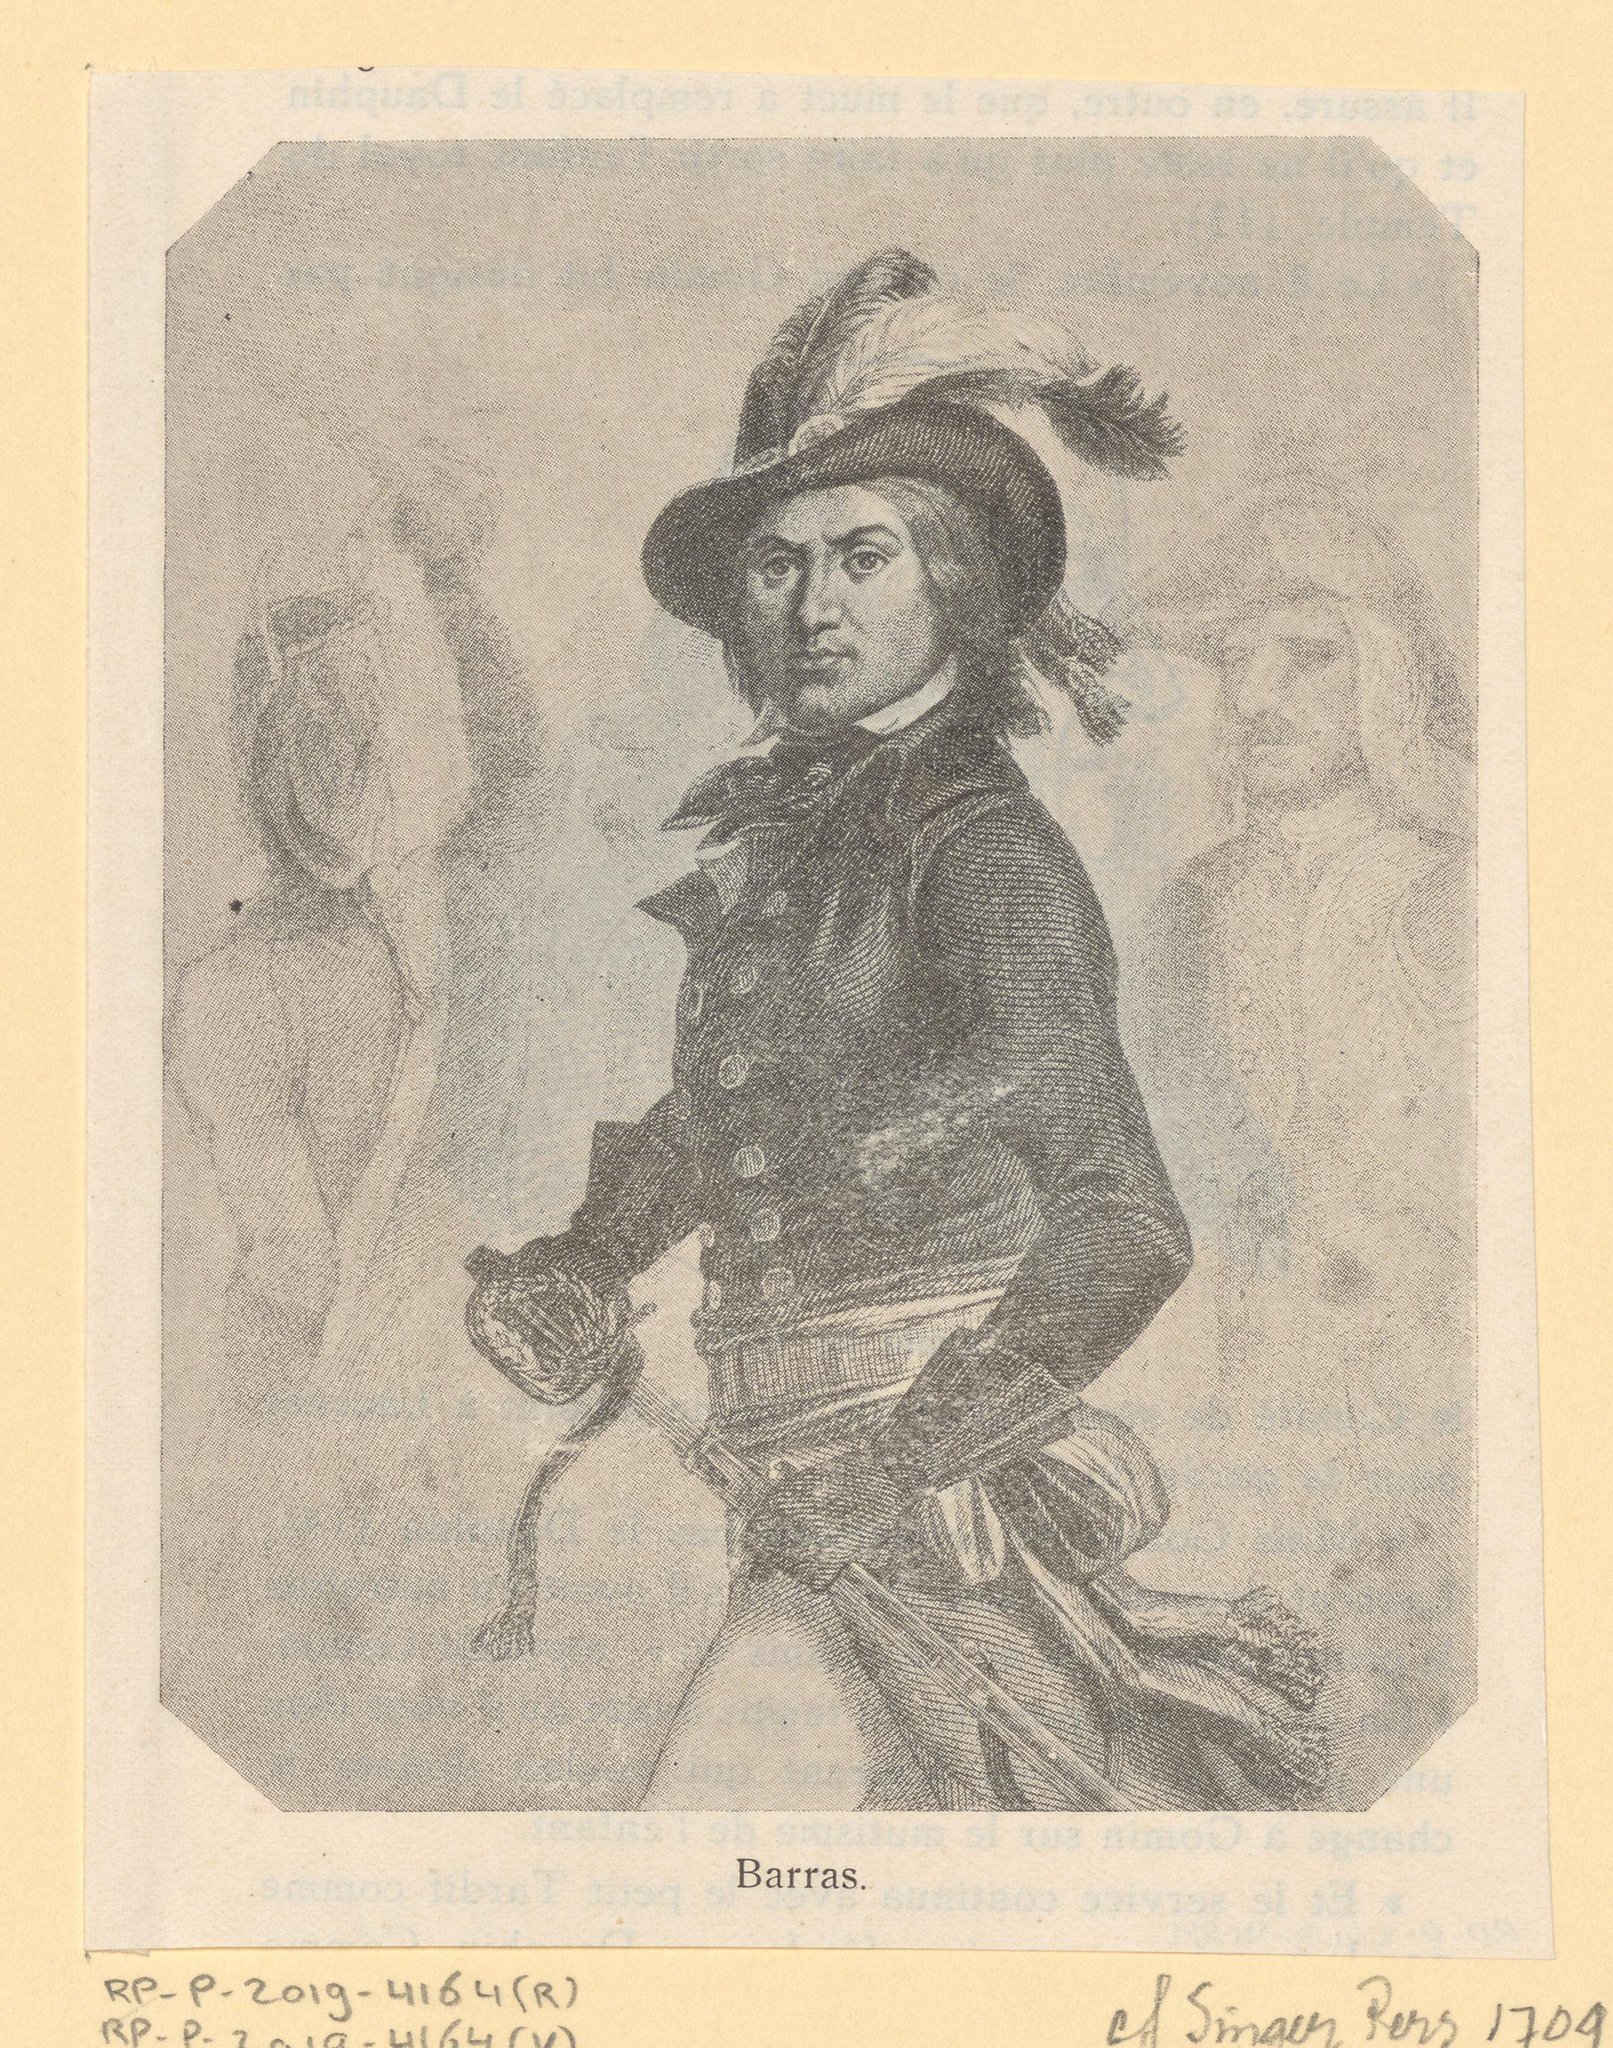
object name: book illustration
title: Portret van Paul Barras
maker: Anonymous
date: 1900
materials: paper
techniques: letterpress printing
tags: politician, historical persons